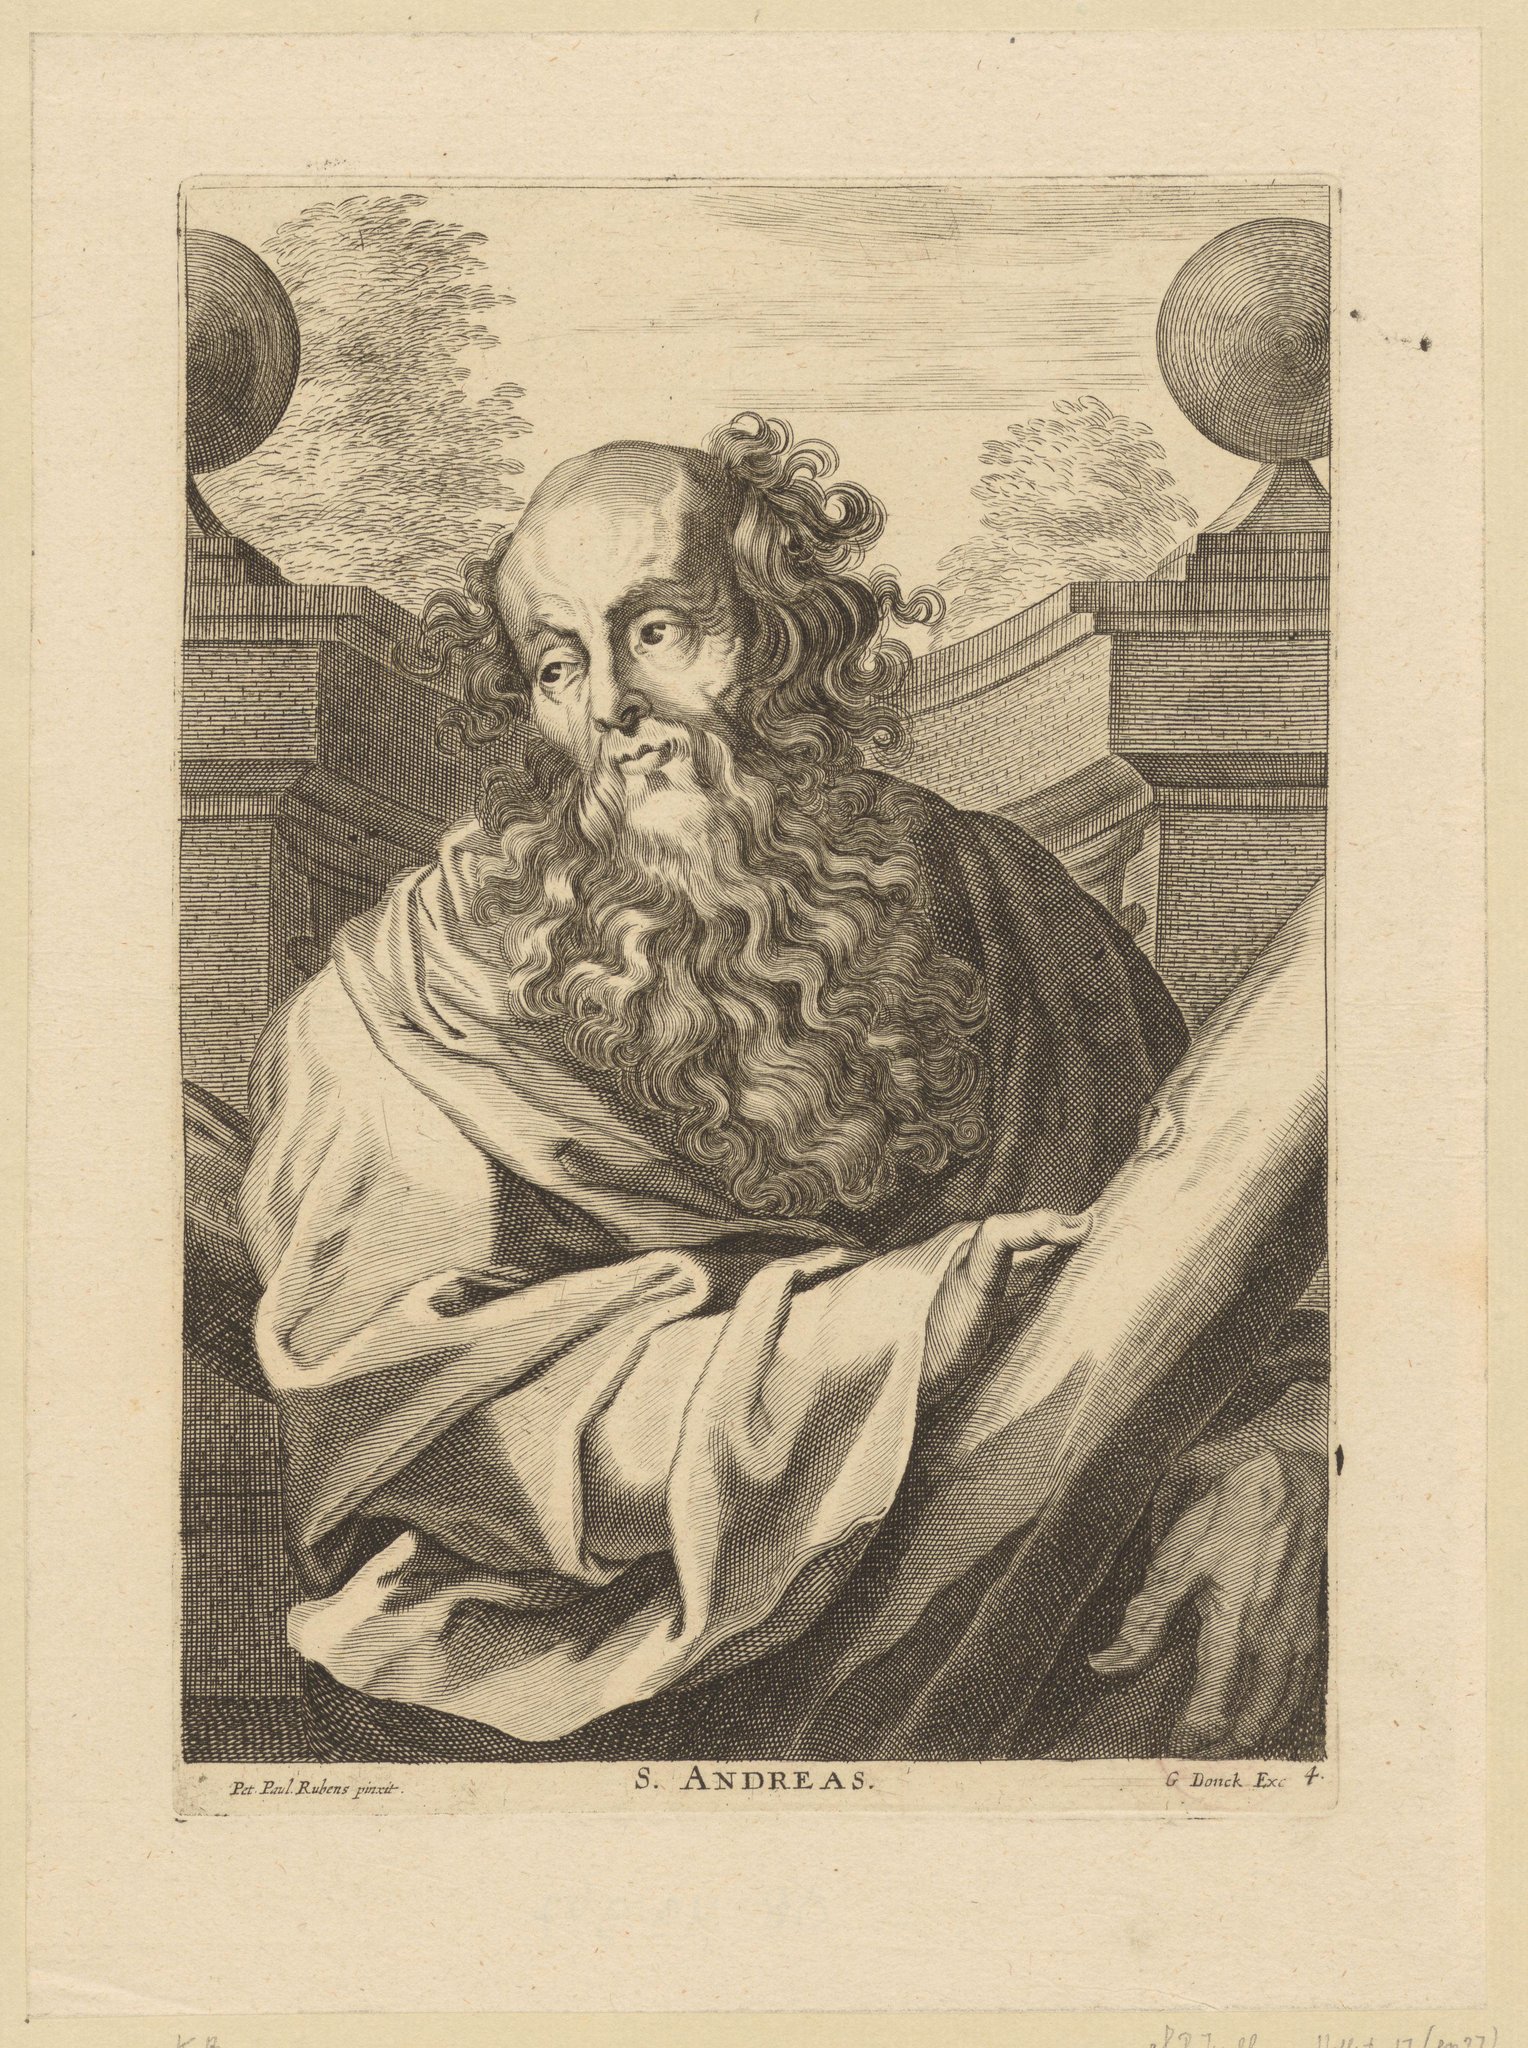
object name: print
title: H. Andreas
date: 1611-1612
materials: paper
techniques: engraving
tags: the apostle andrew; possible attributes: book, x-shaped cross, fish, fishing-net, rope, scroll